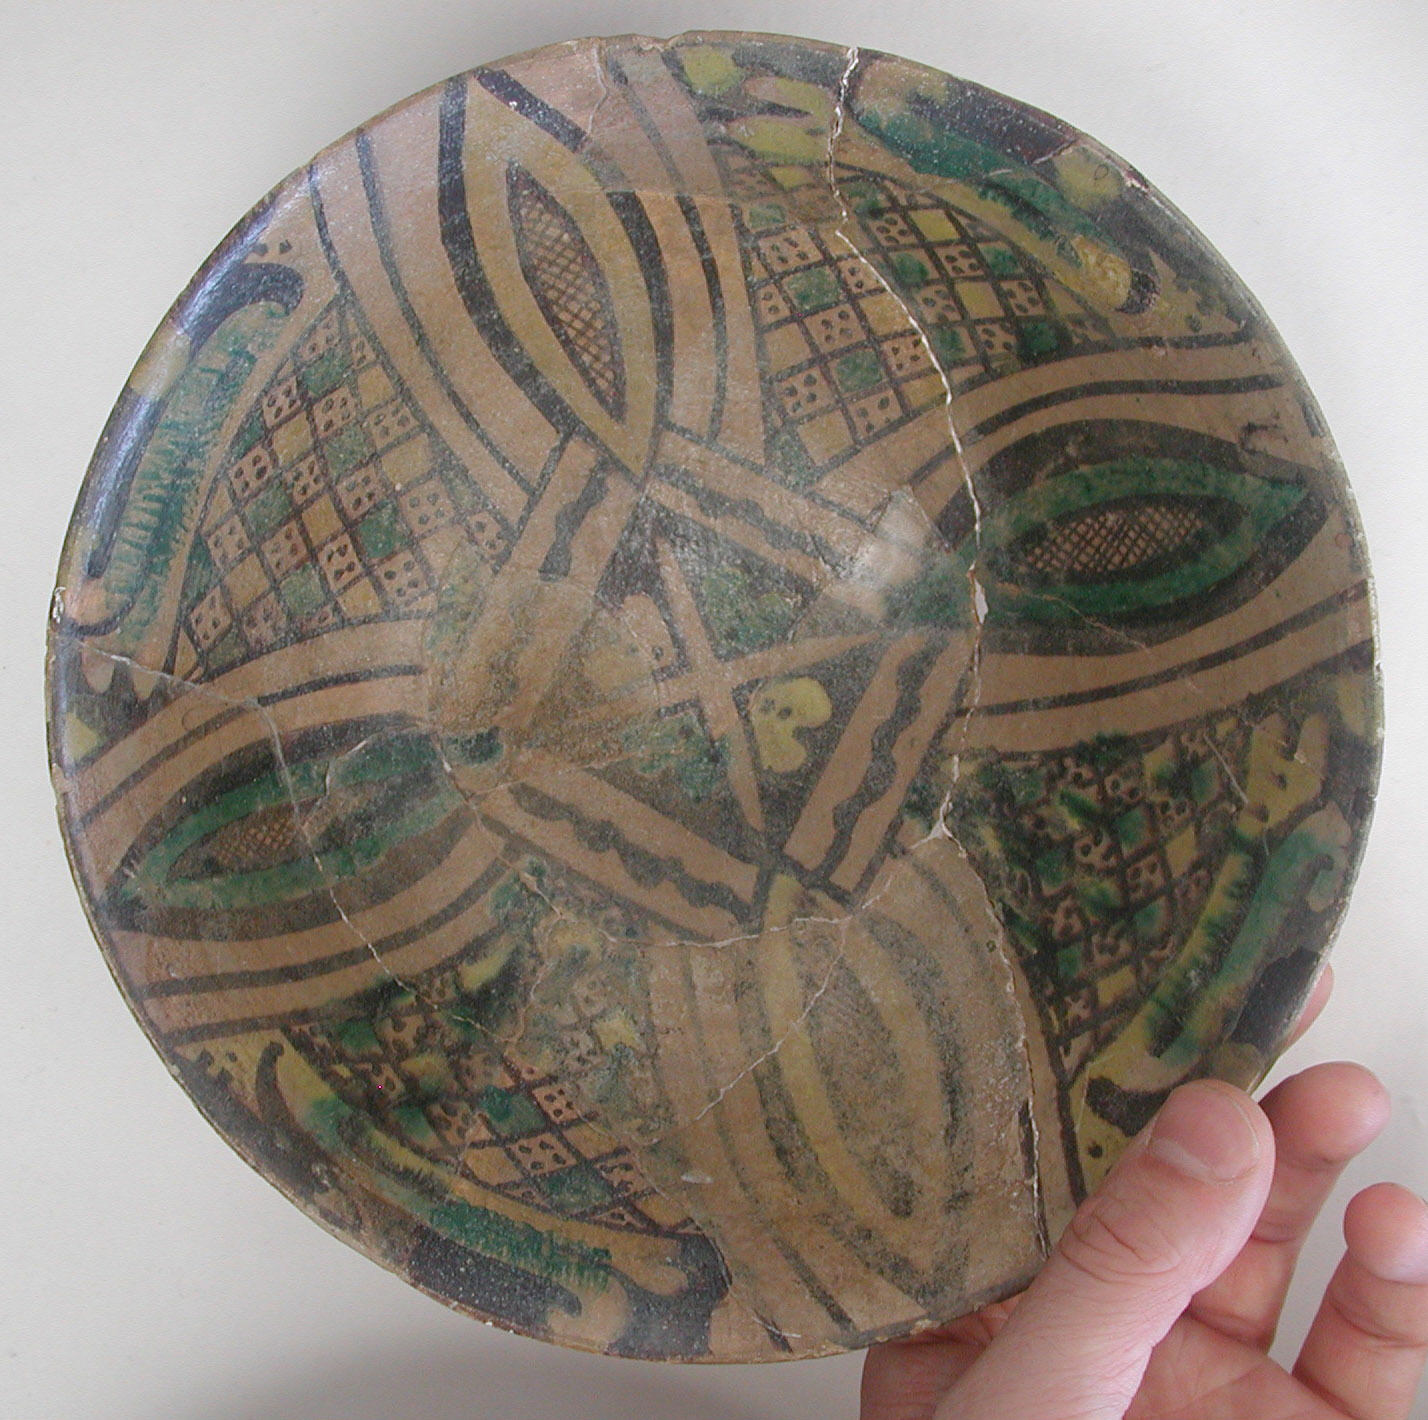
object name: bowl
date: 801-900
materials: earthenware, glaze, pigment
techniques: painting, polychrome, underglaze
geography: iran